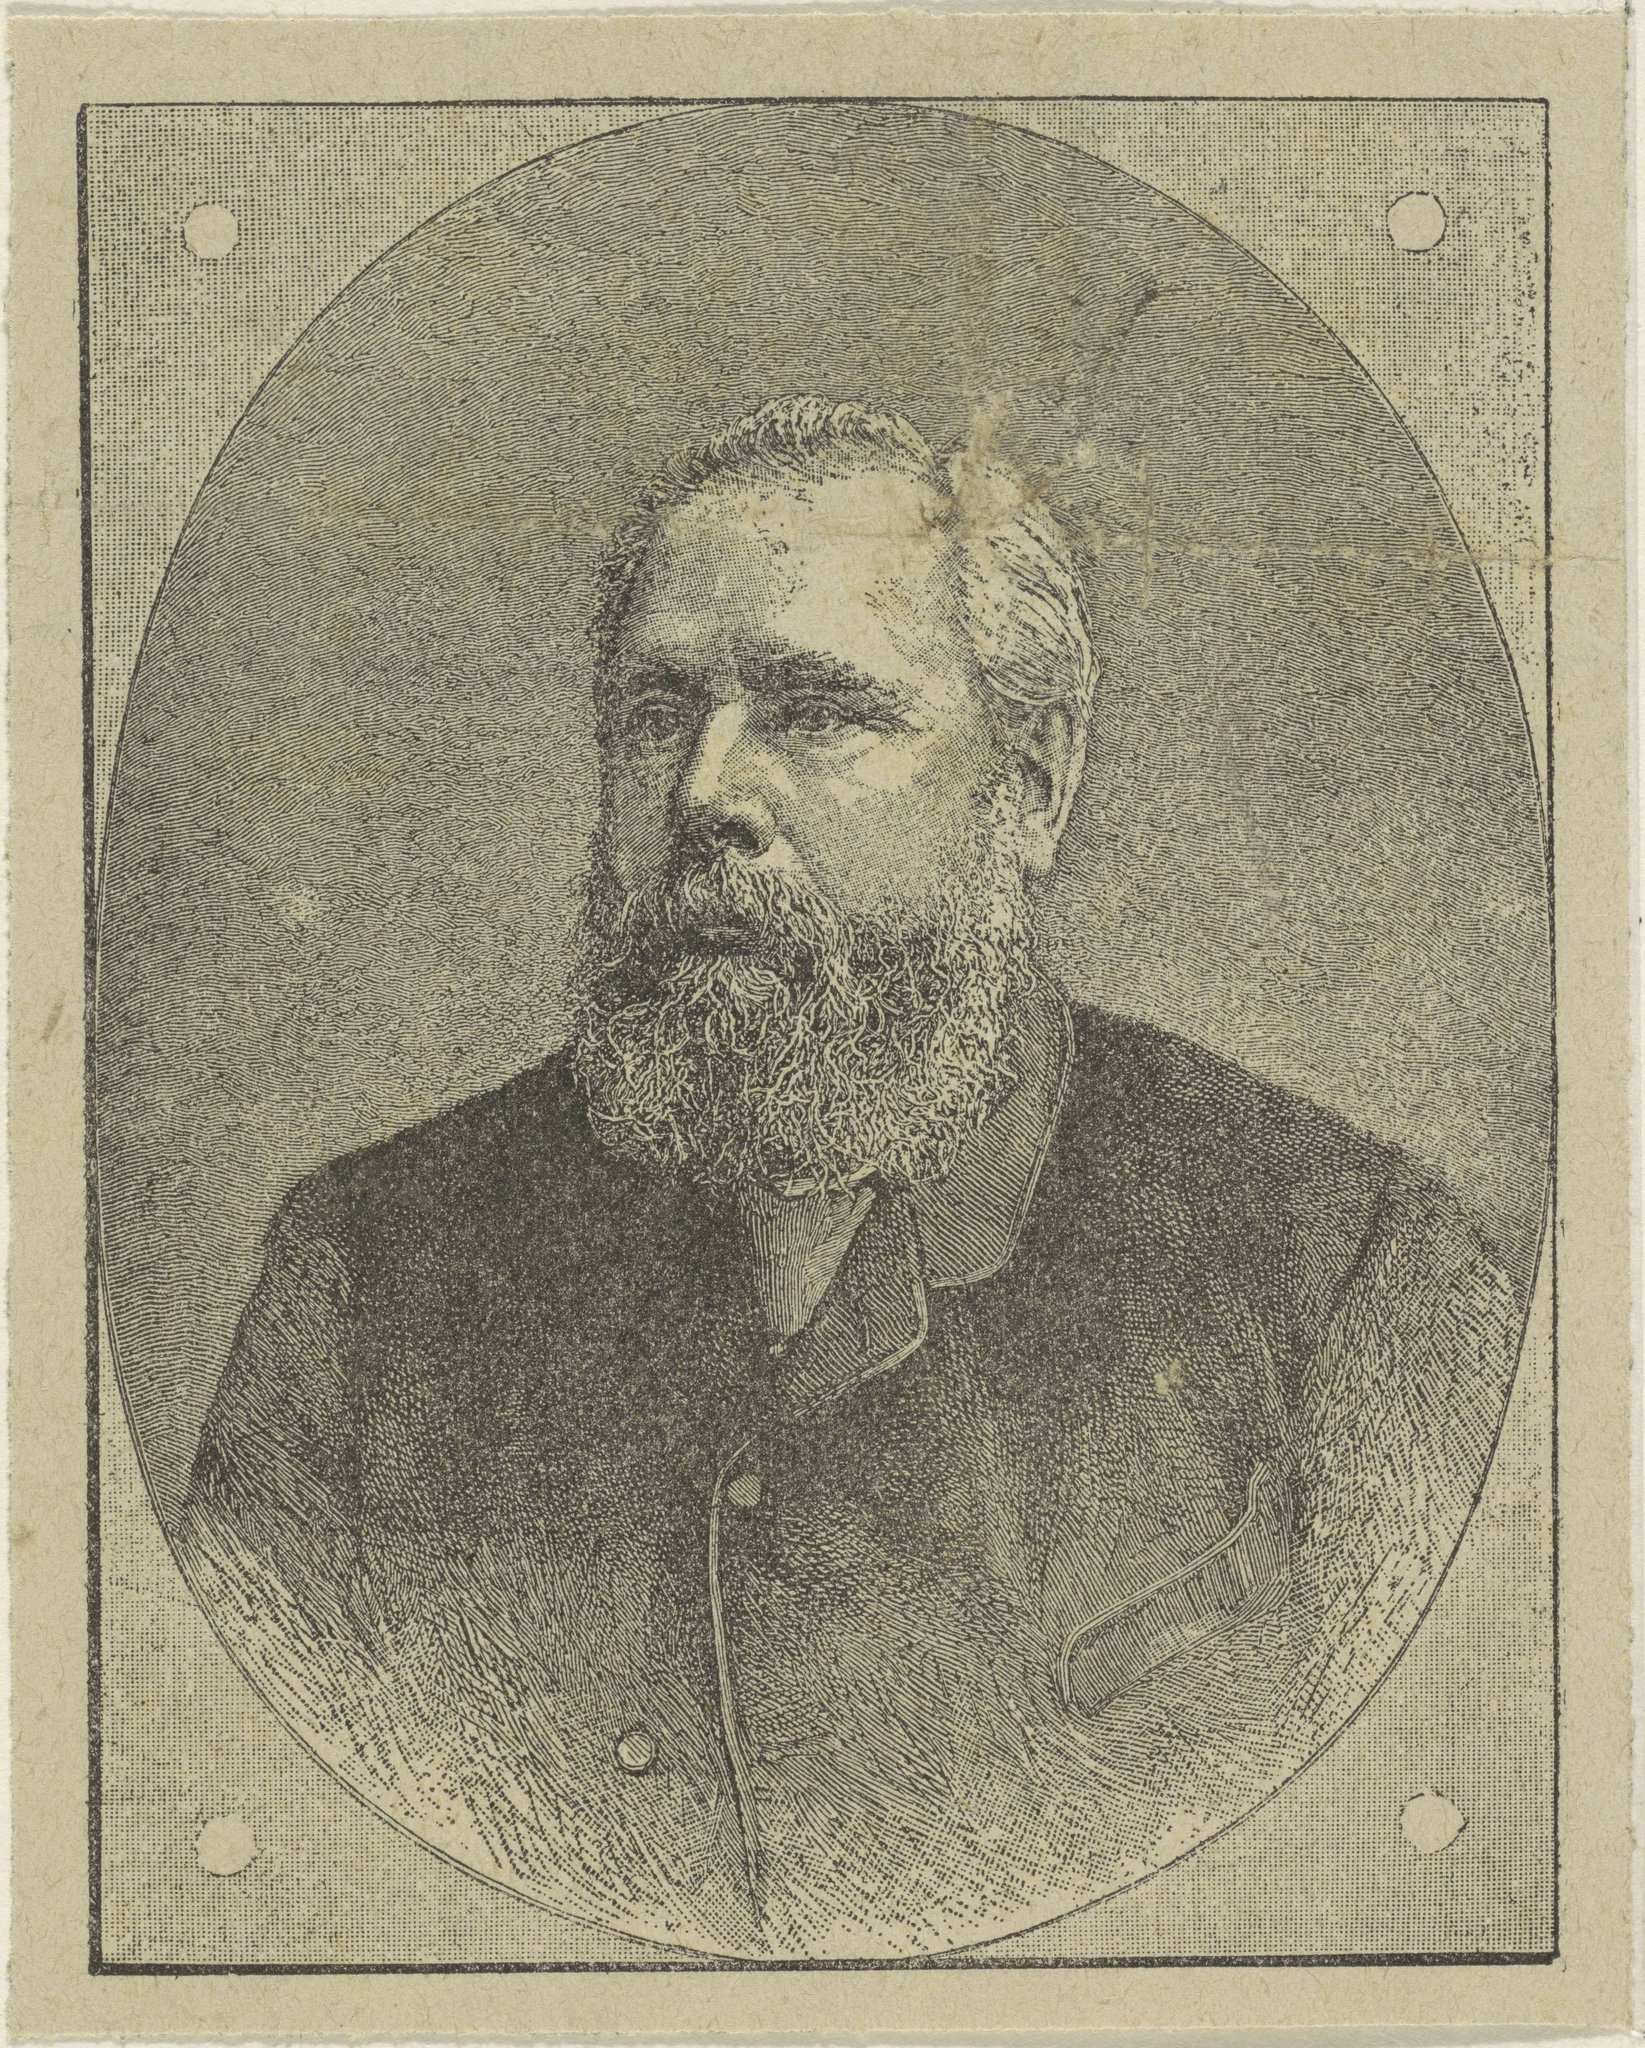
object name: book illustration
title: Portret van Willem III, koning der Nederlanden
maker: Anonymous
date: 1849-1899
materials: paper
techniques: letterpress printing, engraving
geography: netherlands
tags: willem iii (koning der nederlanden)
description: De hier vermelde titel verwijst naar de hoogst verkregen titel van de geportretteerde, niet per se naar de titel die de geportretteerde op deze voorstelling draagt.